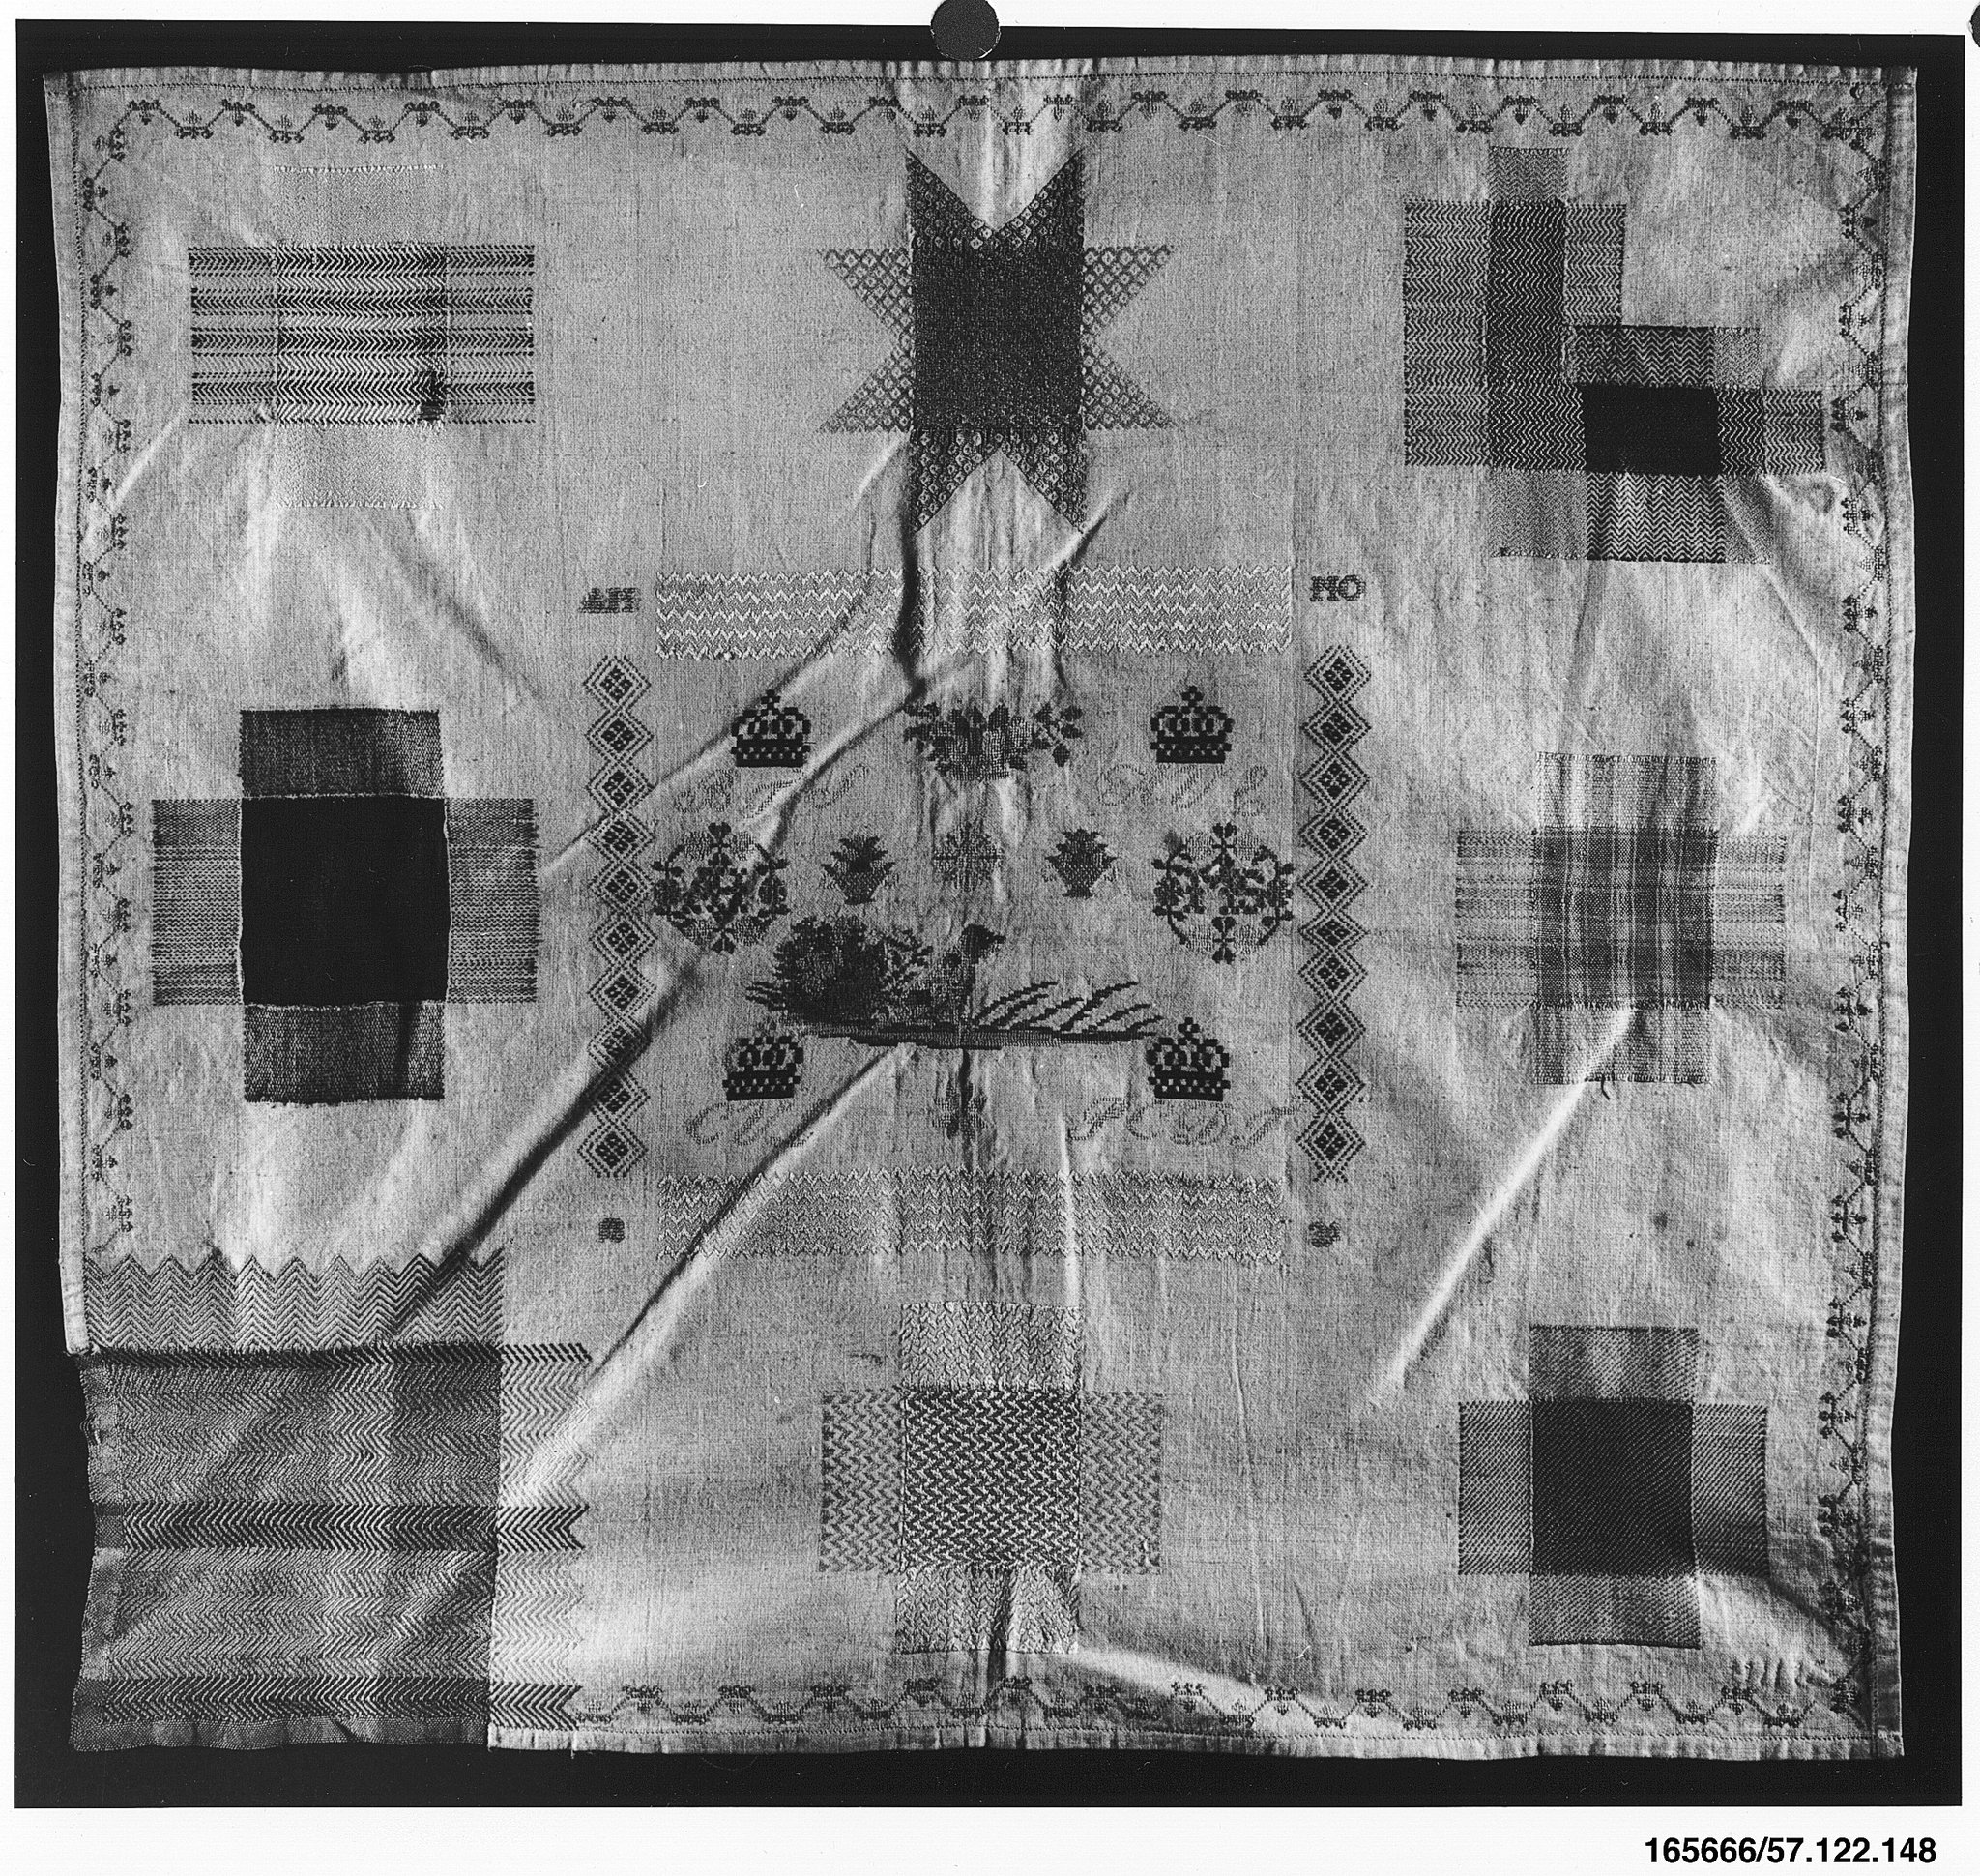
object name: sampler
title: Embroidered darning sampler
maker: werk- en leerschool, amsterdam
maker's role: manufactory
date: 1839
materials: cotton, silk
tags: birds